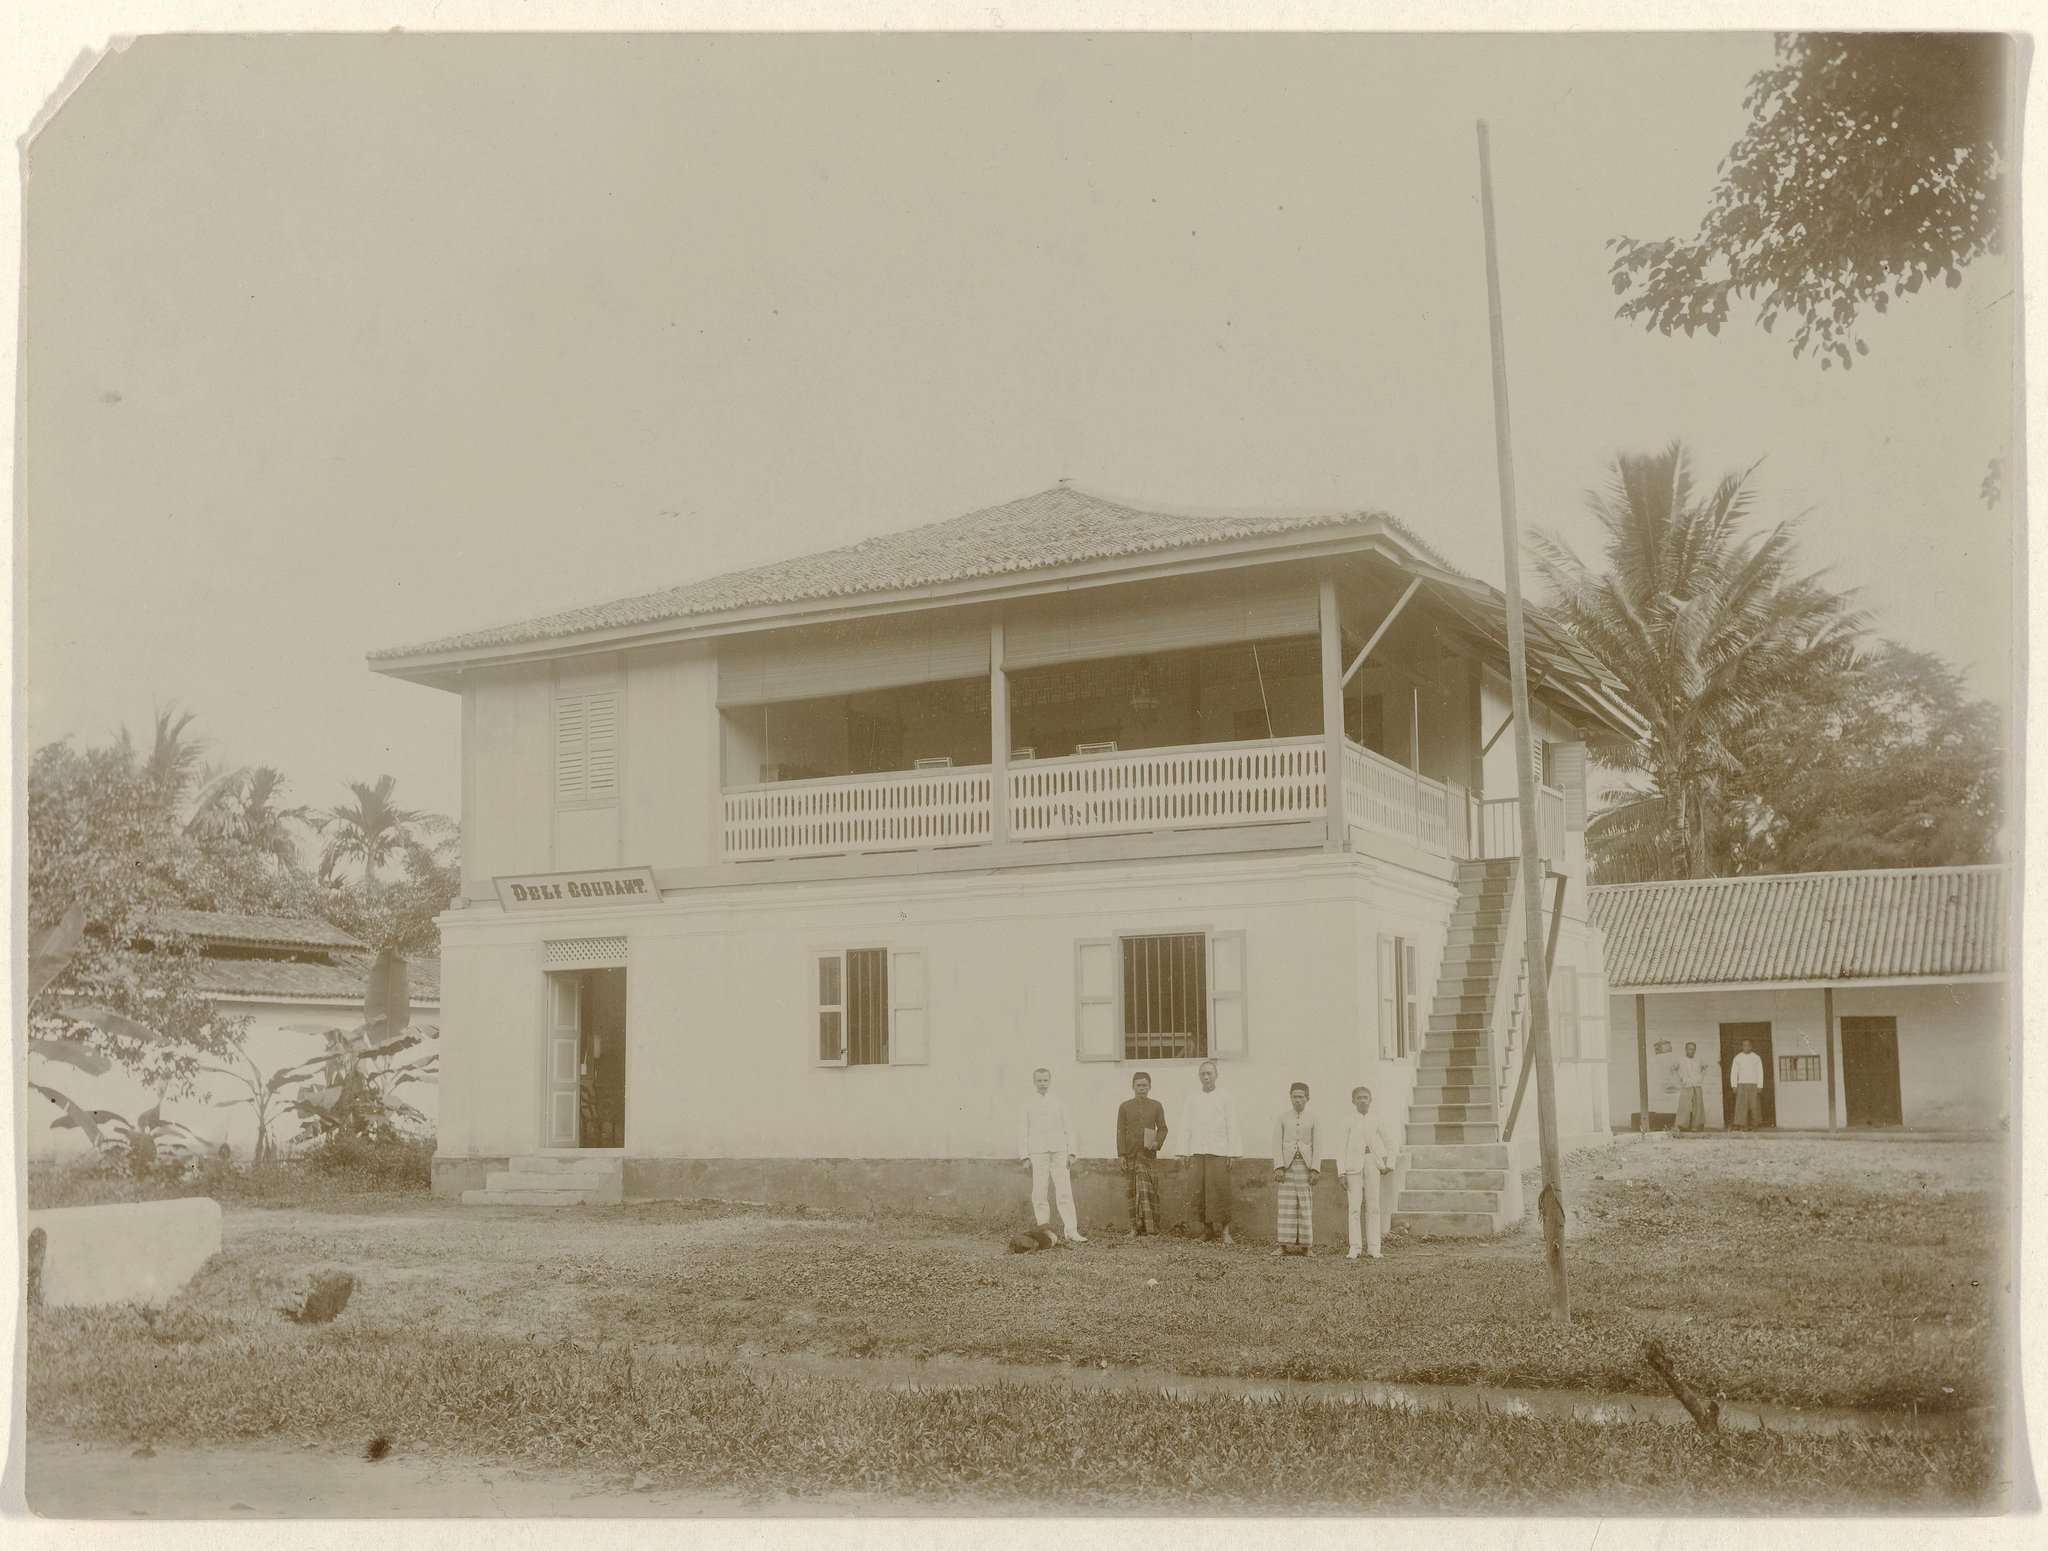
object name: photograph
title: Drukkerij van de Deli Courant te Tandjong Poera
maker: Anonymous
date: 1809-1898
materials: photographic support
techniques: collodion silver print, gelatin silver print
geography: medan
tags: dutch east indies, the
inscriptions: inscription: ‘Drukkerij Tandjong-Poera’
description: Gezicht op de drukkerij van de Deli Courant te Tandjong Poera, voor het gebouw poseren enkele staande mannen. Onderdeel van een groep van 8 foto's uit september 1898 binnen de groep van 49 losse zwart-wit foto's van verschillend formaat over de uitgeverij en drukkerij van de krant Deli Courant in Medan in de periode 1885-1947.